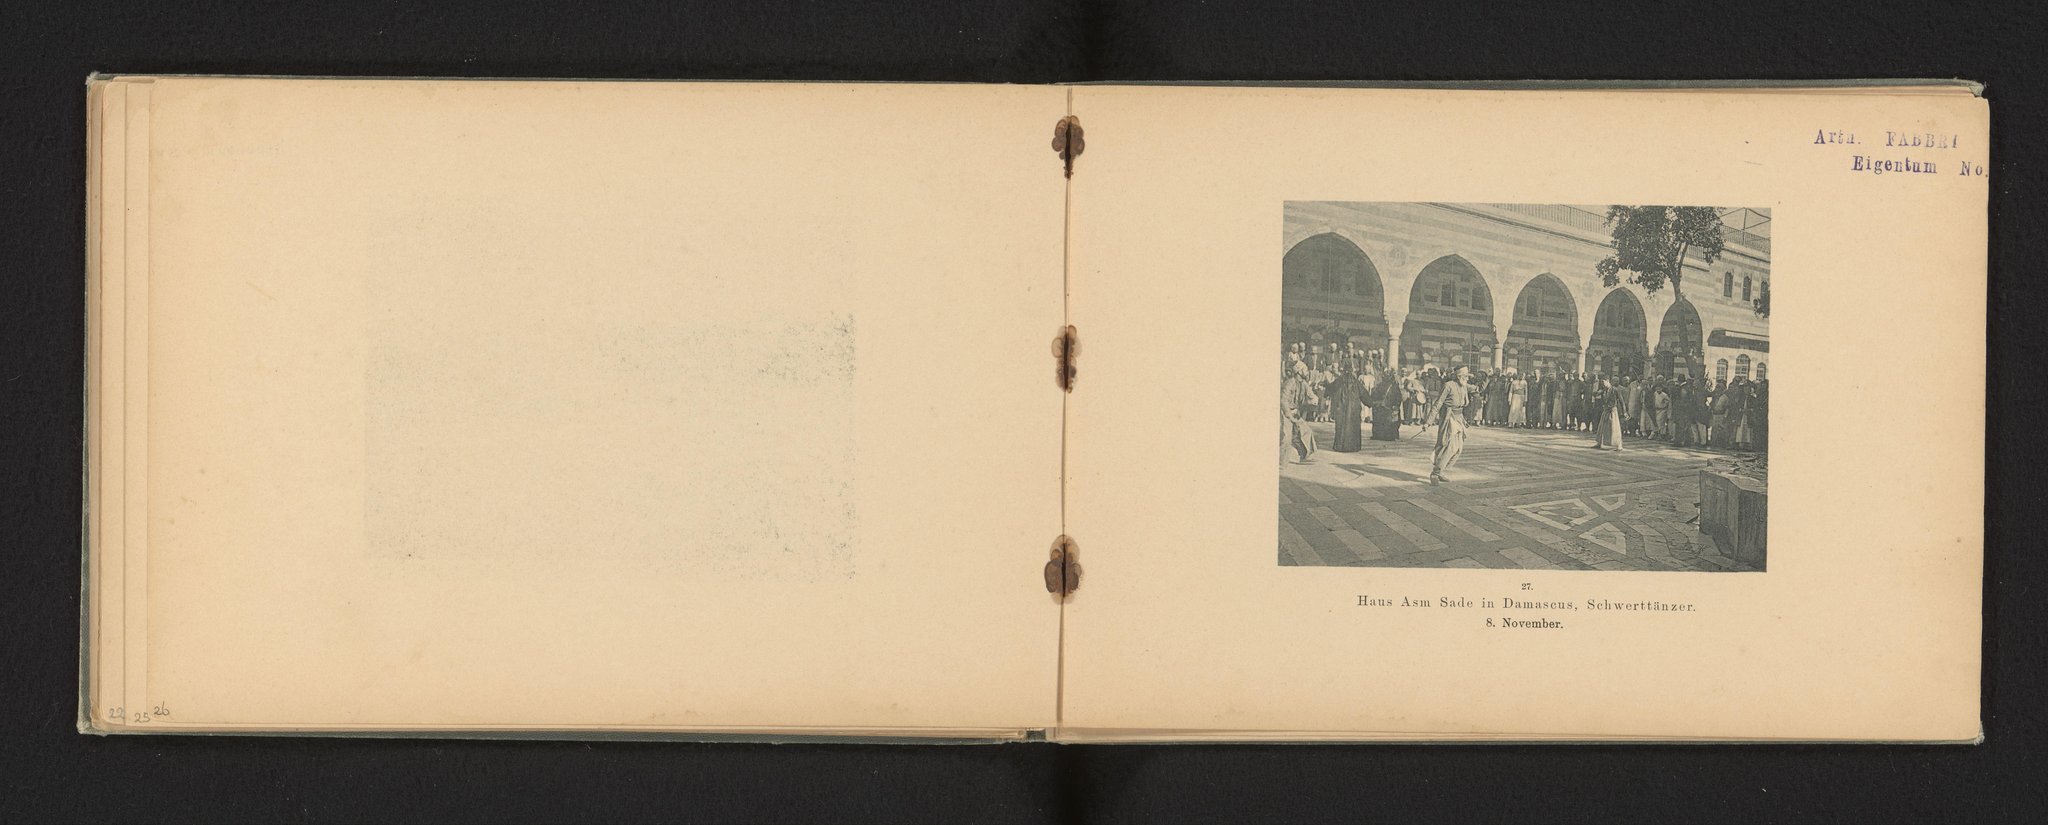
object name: page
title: Haus Asm Sade in Damascus, Schwerttänzer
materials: paper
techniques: photograph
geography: damascus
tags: square, place, circus, etc., dancing (+ out of doors (sports, games, etc.))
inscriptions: collector's mark: ‘Art[h]. FABBRI/ Eigentum No.’, number: ‘27.’